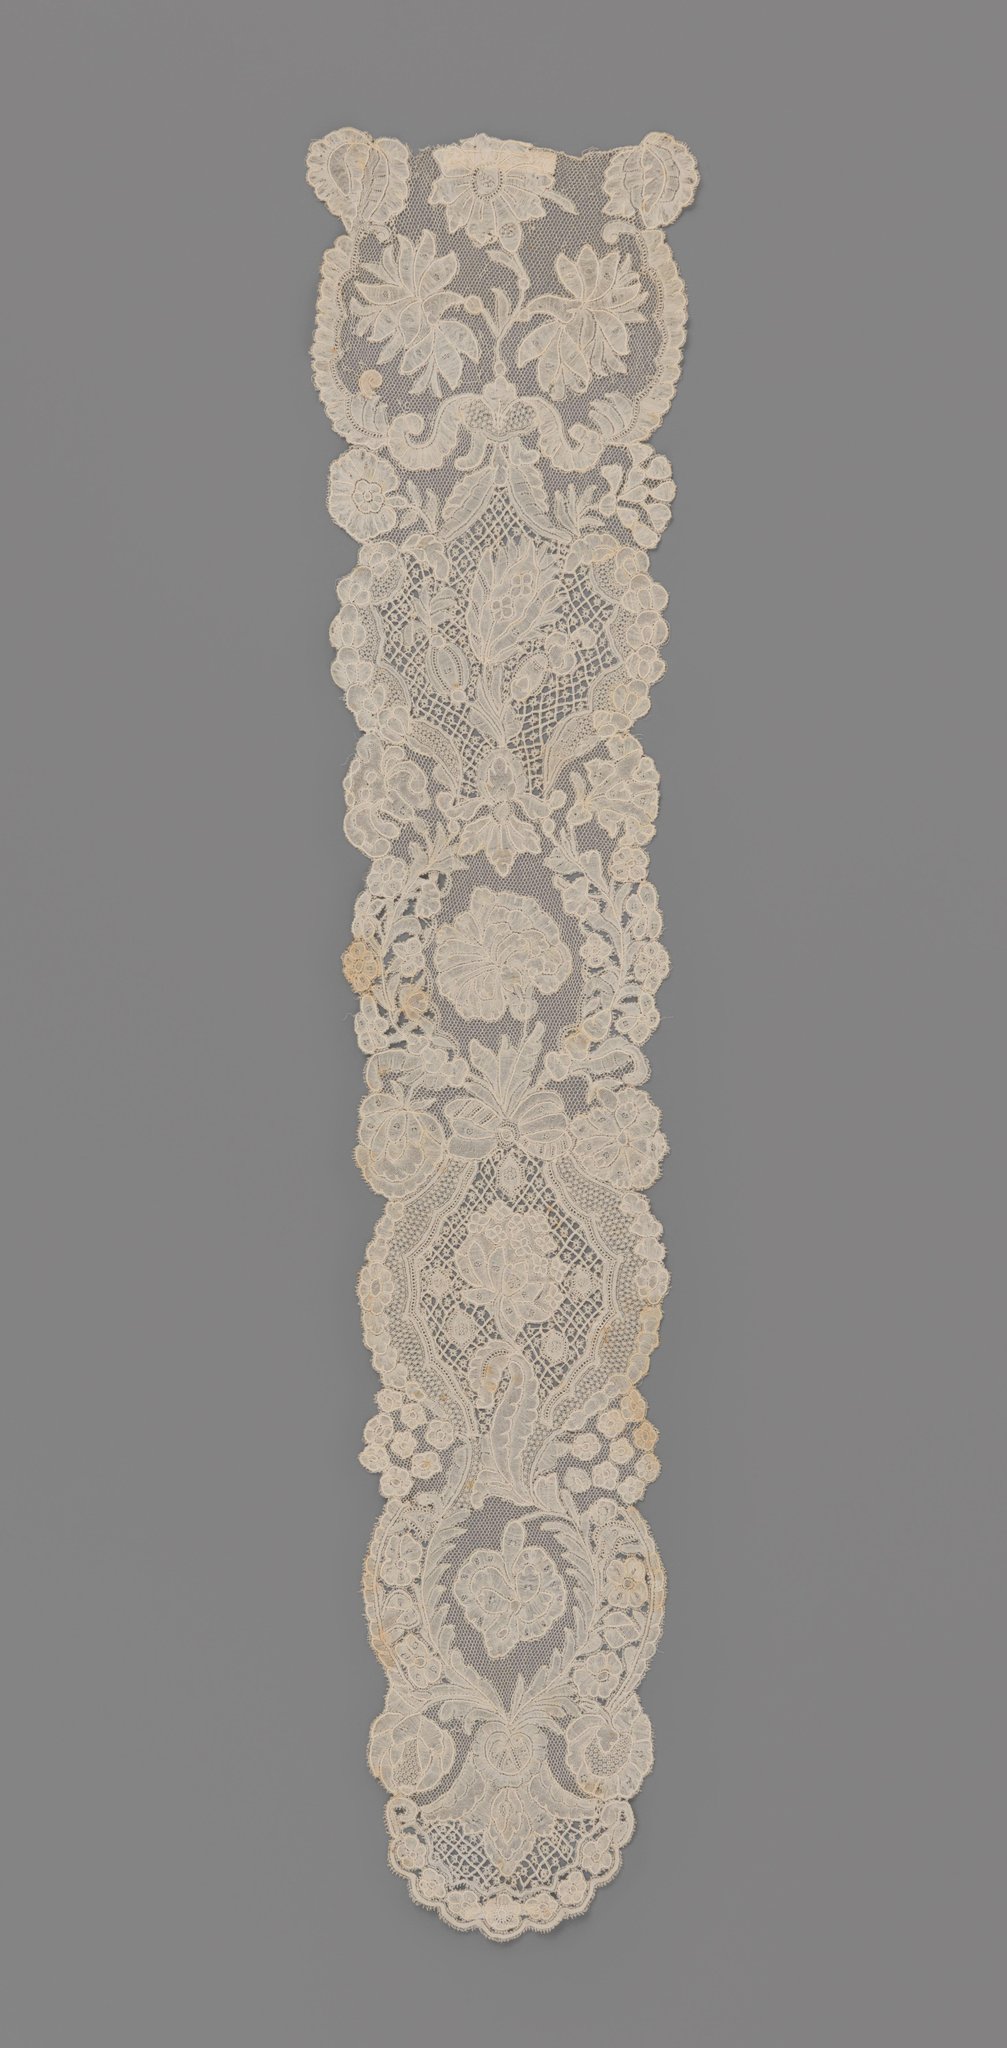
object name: lappet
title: Mutsenslip (barbe) van Brusselse kloskant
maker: Anonymous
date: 1715-1725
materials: linen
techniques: lace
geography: belgium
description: Mutsenslip (barbe) van Brusselse kloskant. Het patroon bestaat uit bloemen en bloemtakken op verschillende gronden. De gevarieerd geschulpte rand is voorzien van picots en heeft een rond uiteinde.